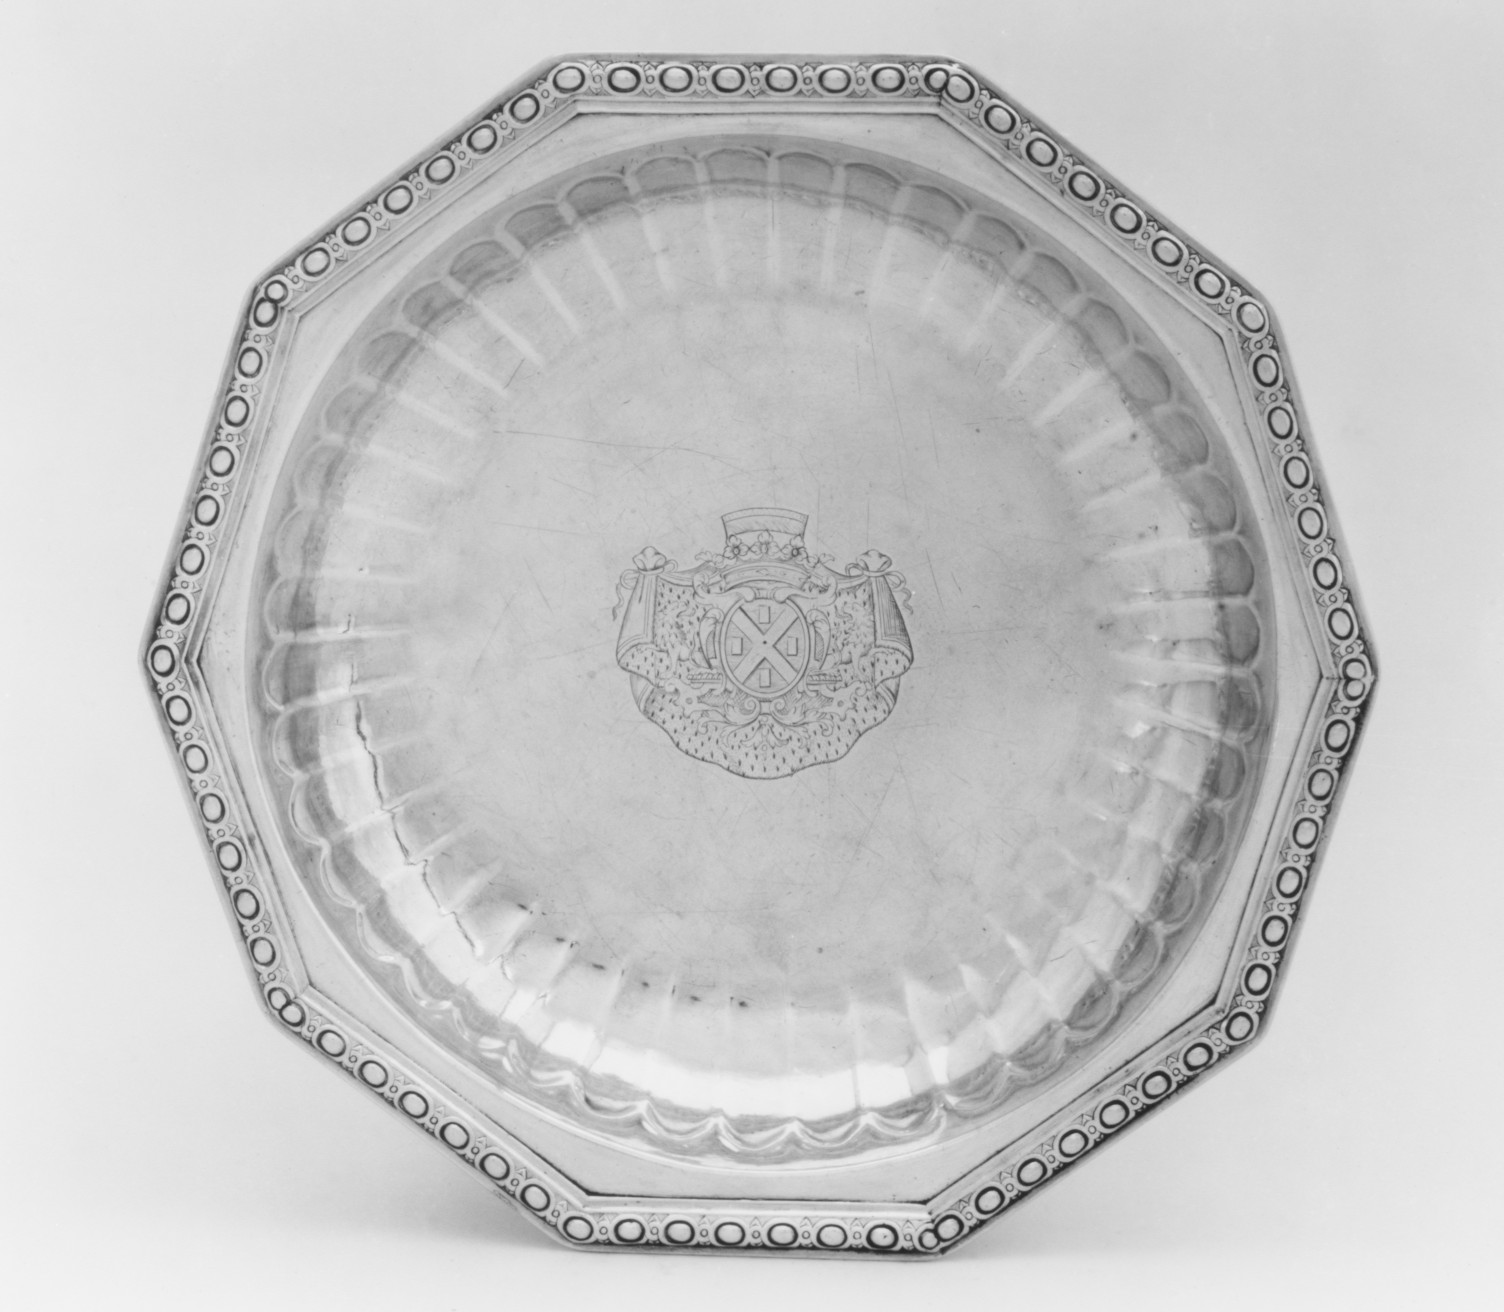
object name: dish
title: Dish (one of a pair)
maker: jean-baptiste i buchet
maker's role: maker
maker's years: 1694-1801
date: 1726-1728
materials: silver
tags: coat of arms